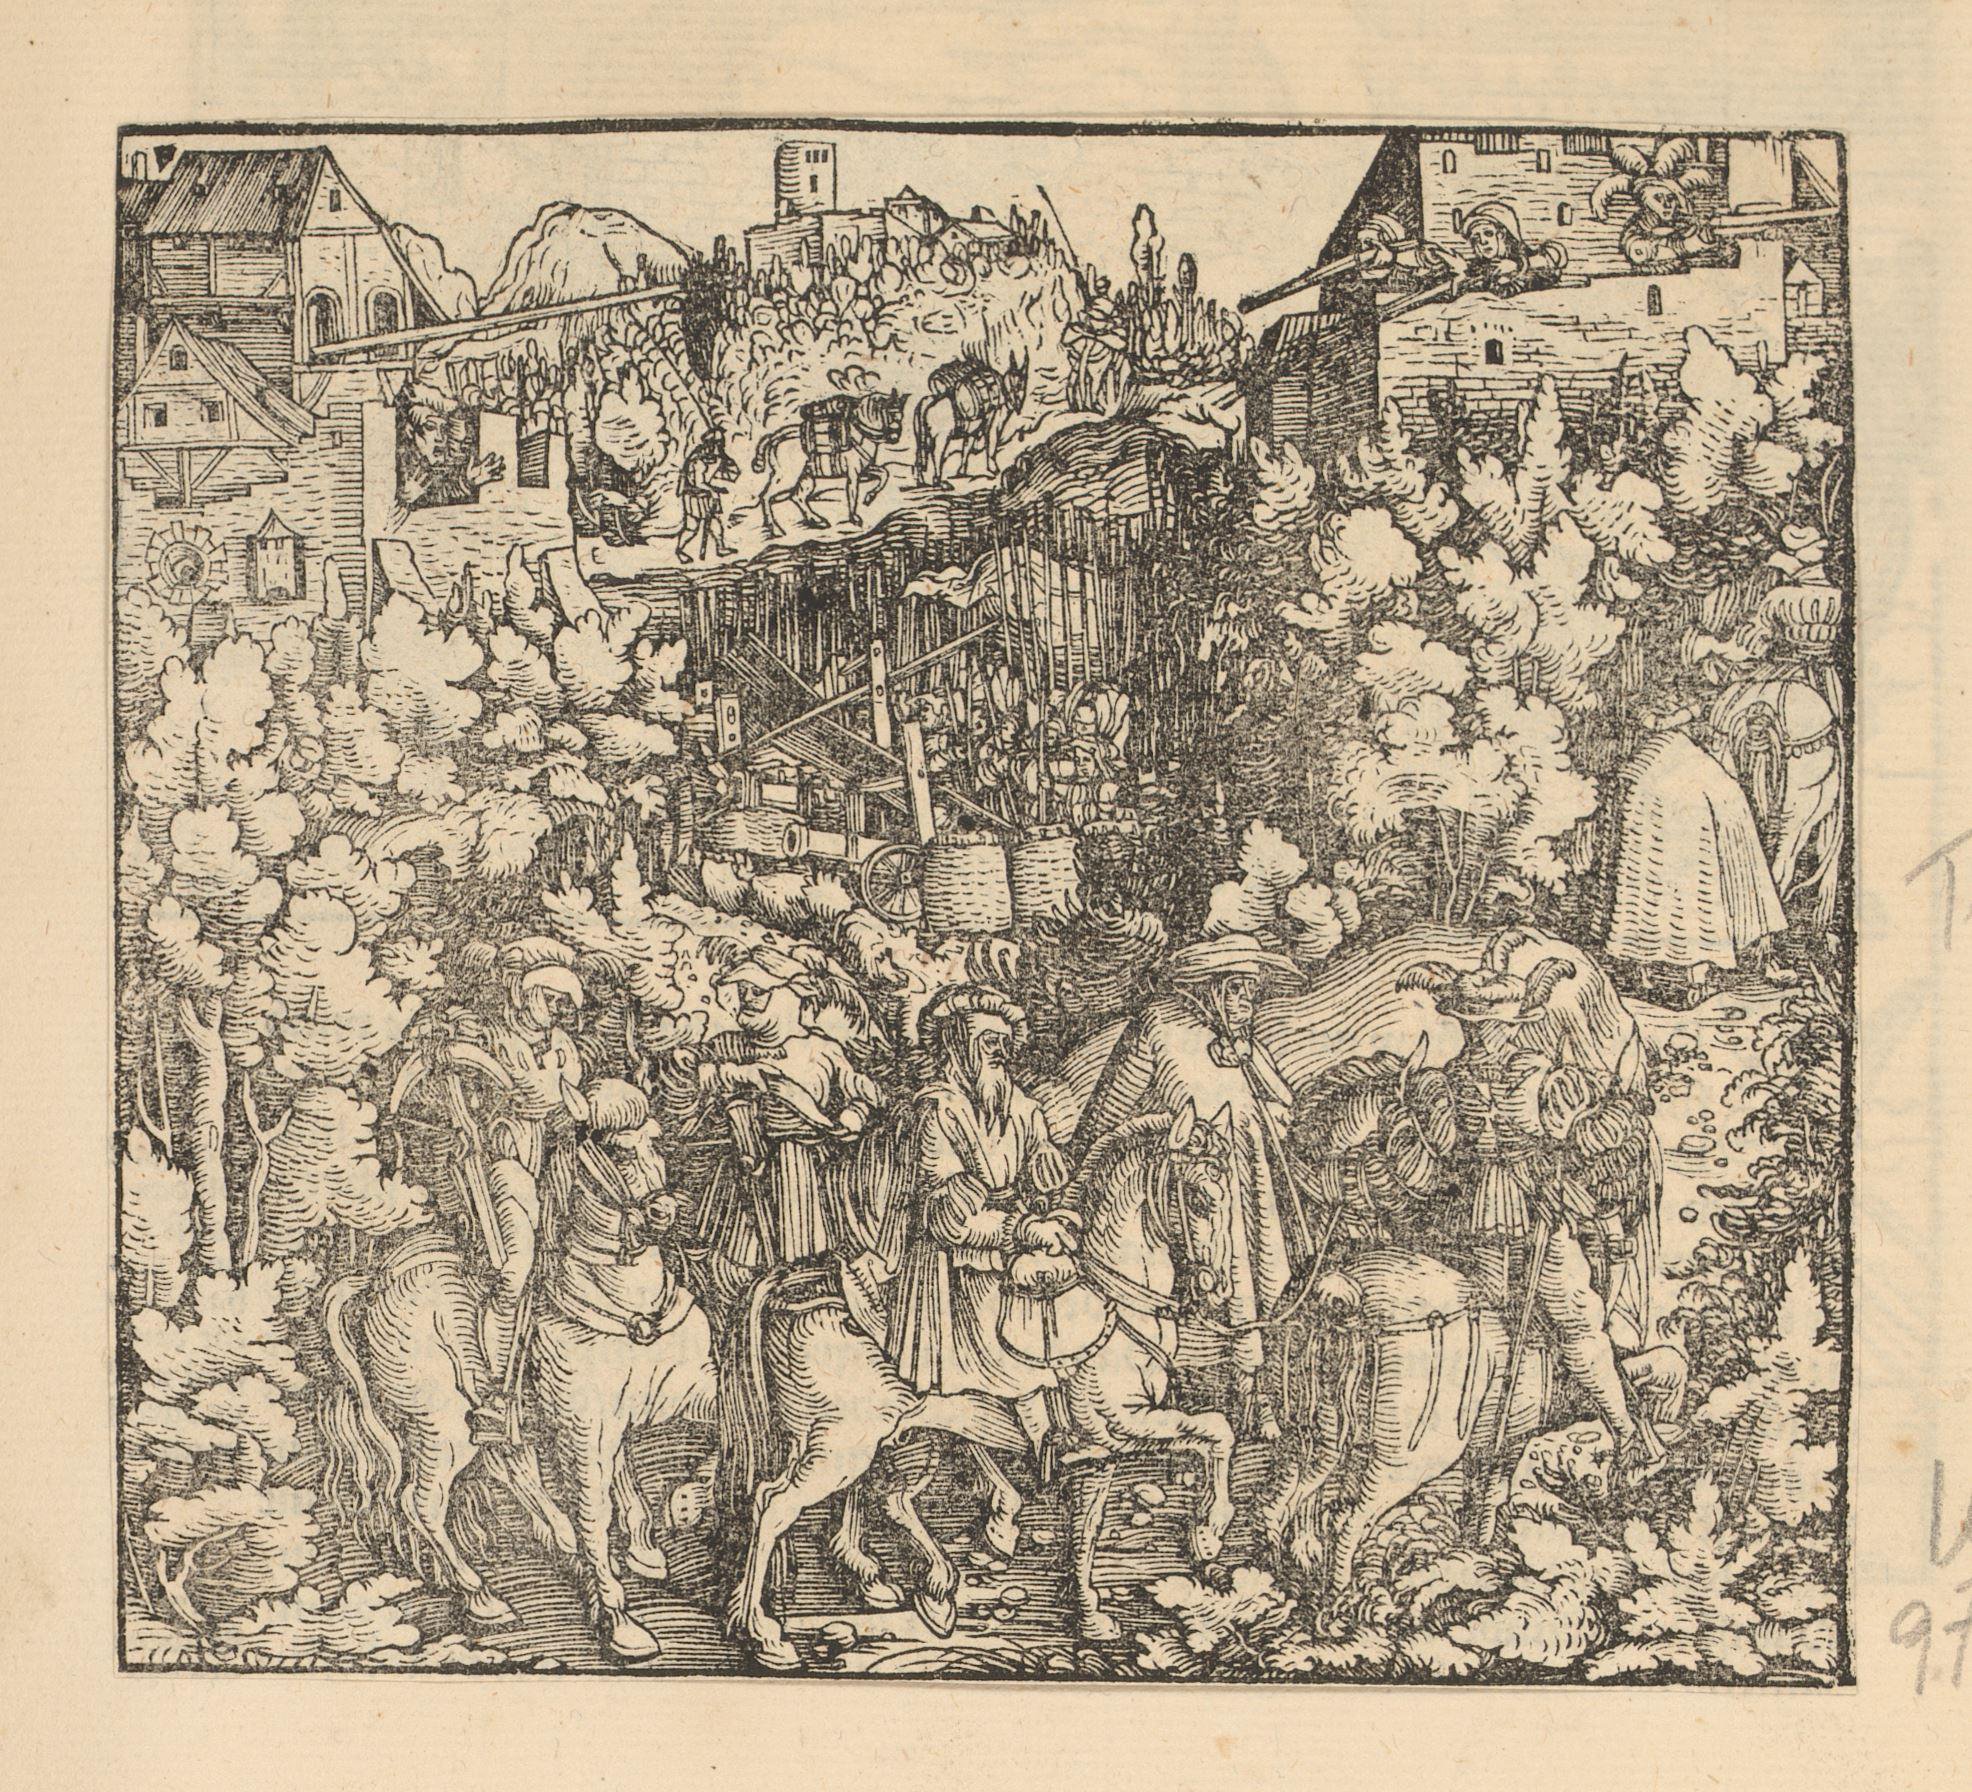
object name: album leaf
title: Inname van een stad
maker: Anonymous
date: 1514-1532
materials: paper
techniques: letterpress printing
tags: capitulation, march into the conquered place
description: Deze prent is gebruikt in: Petrarca, Francesco. Von der Artzney bayder Glück, des guten und widerwertigen: unnd weß sich ain yeder inn Gelück und Unglück halten sol (...). Augsburg: Heinrich Steiner, 1532. Deze uitgave is ook bekend onder de titel 'Trostspiegel in Glück und Unglück'.